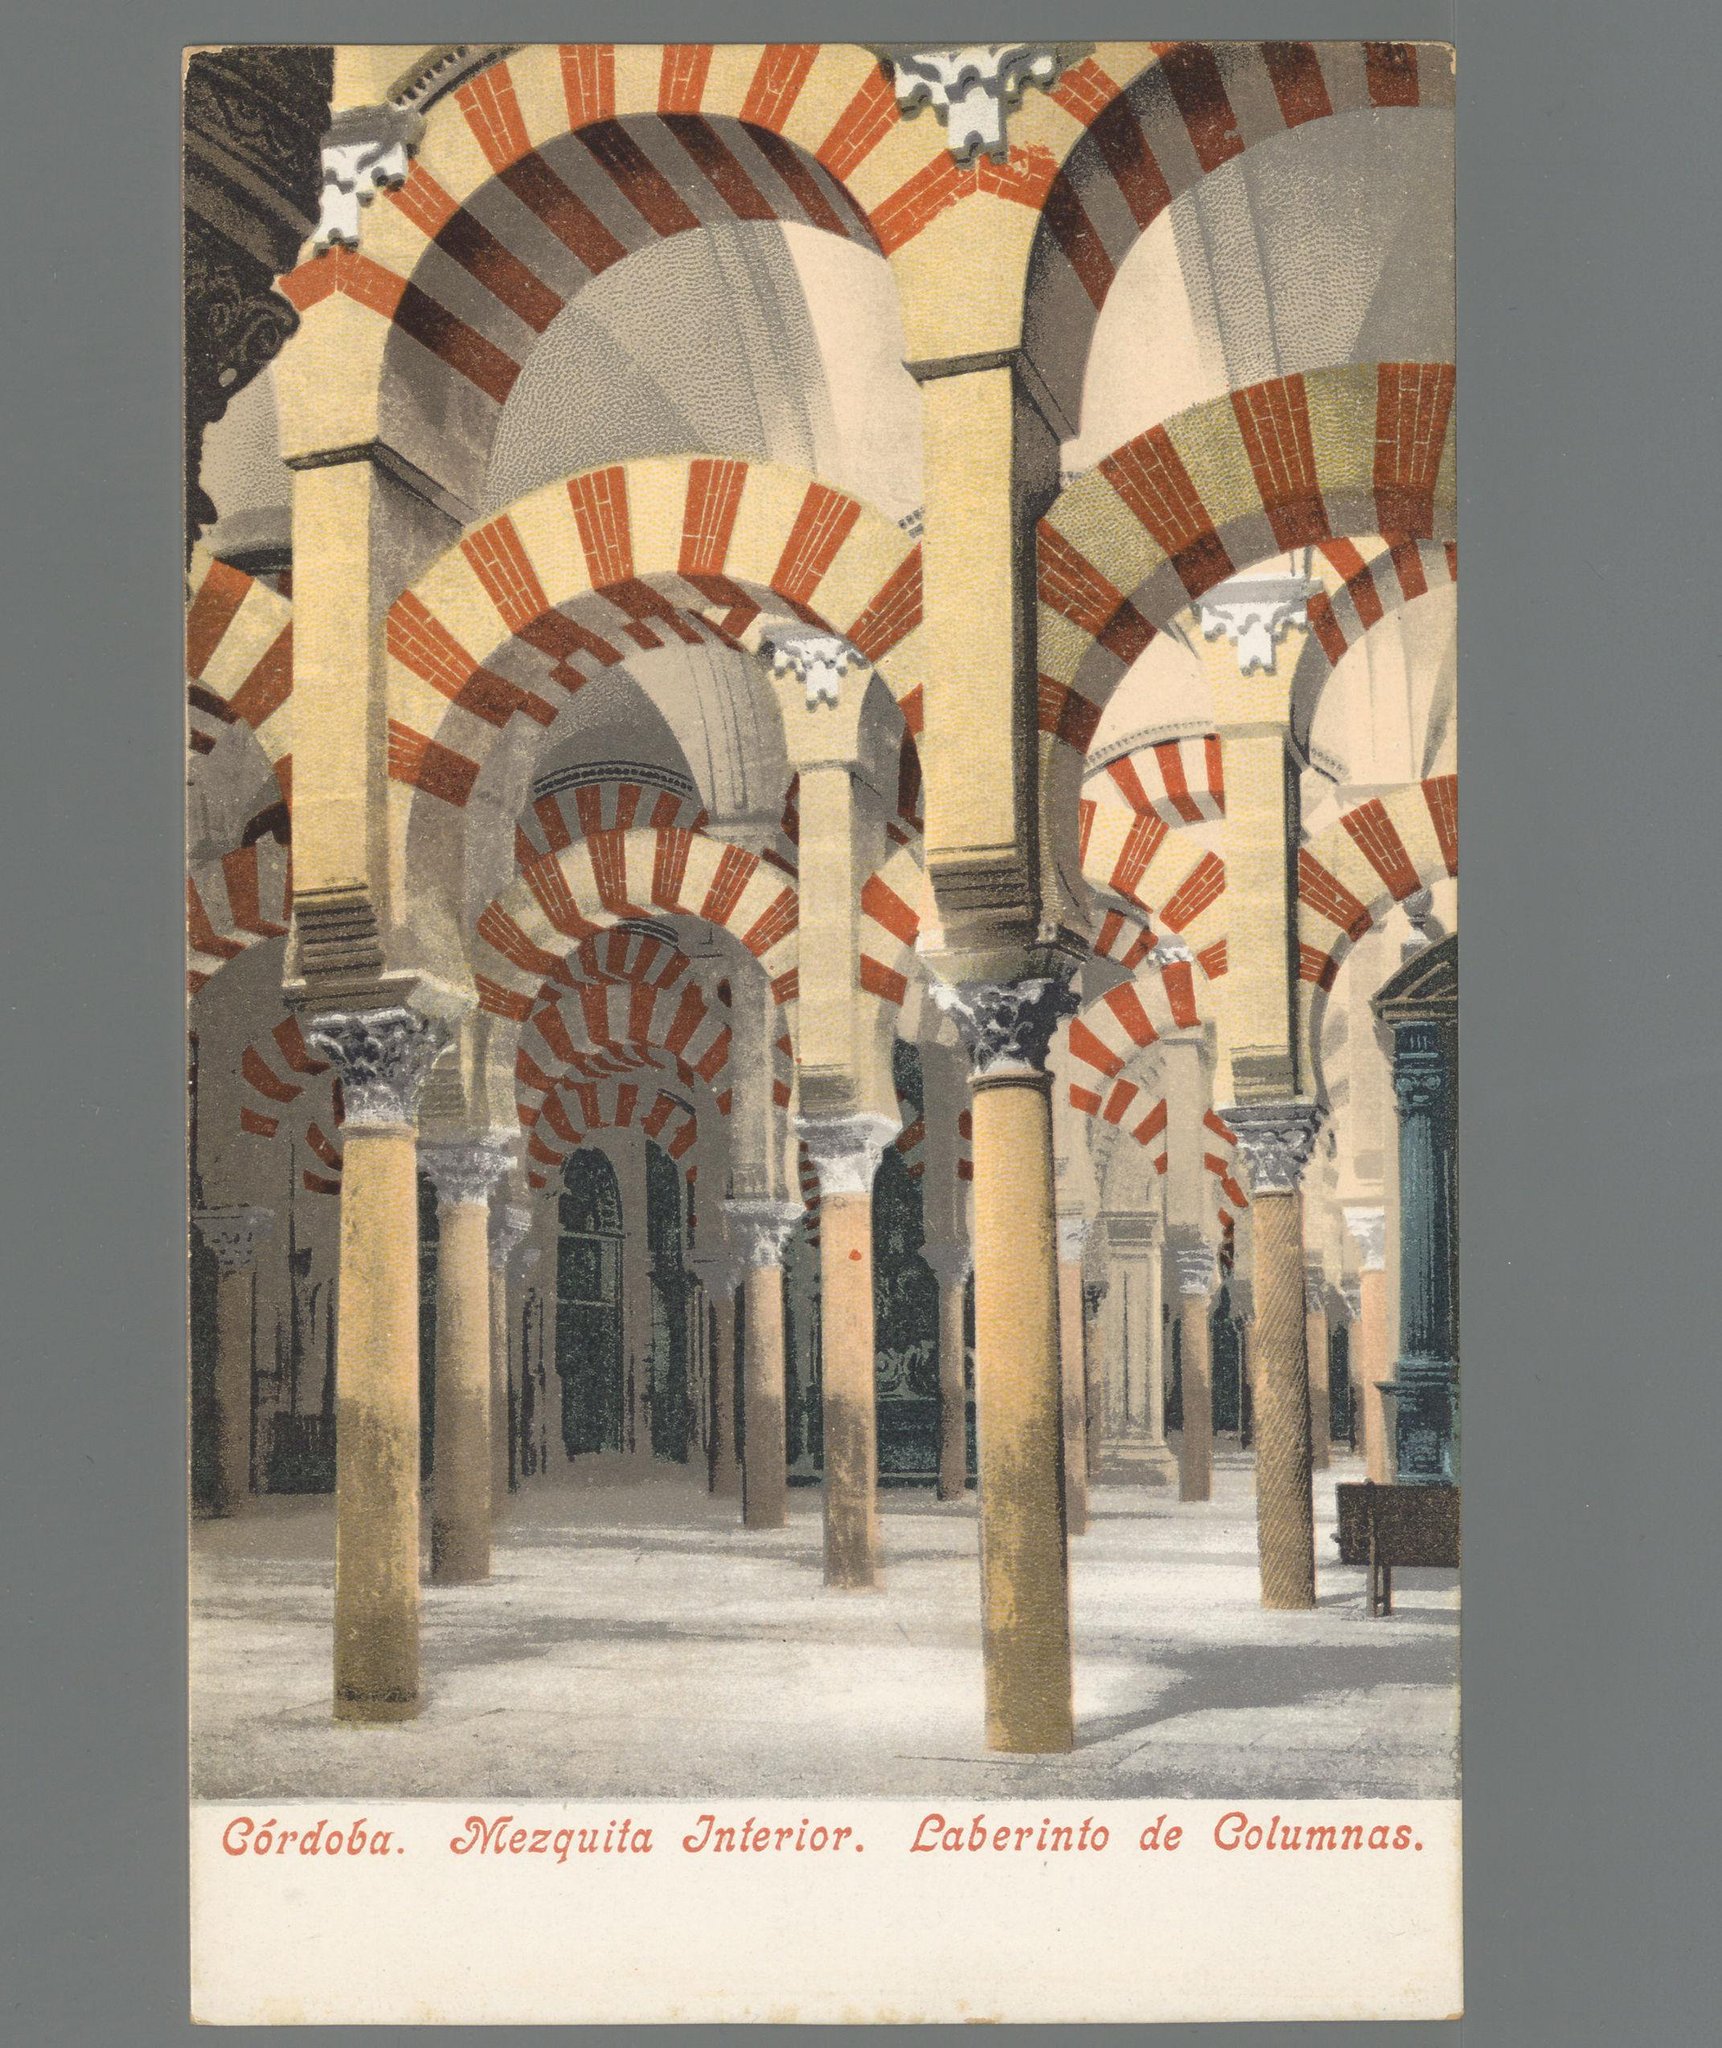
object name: ansichtkaart, prentbriefkaart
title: Córdoba. Mezquita Interior. Laberinto de Columnas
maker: Anonymous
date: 1890-1906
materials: cardboard, photographic process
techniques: writing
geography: córdoba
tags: column, pillar ~ architecture, interior of church